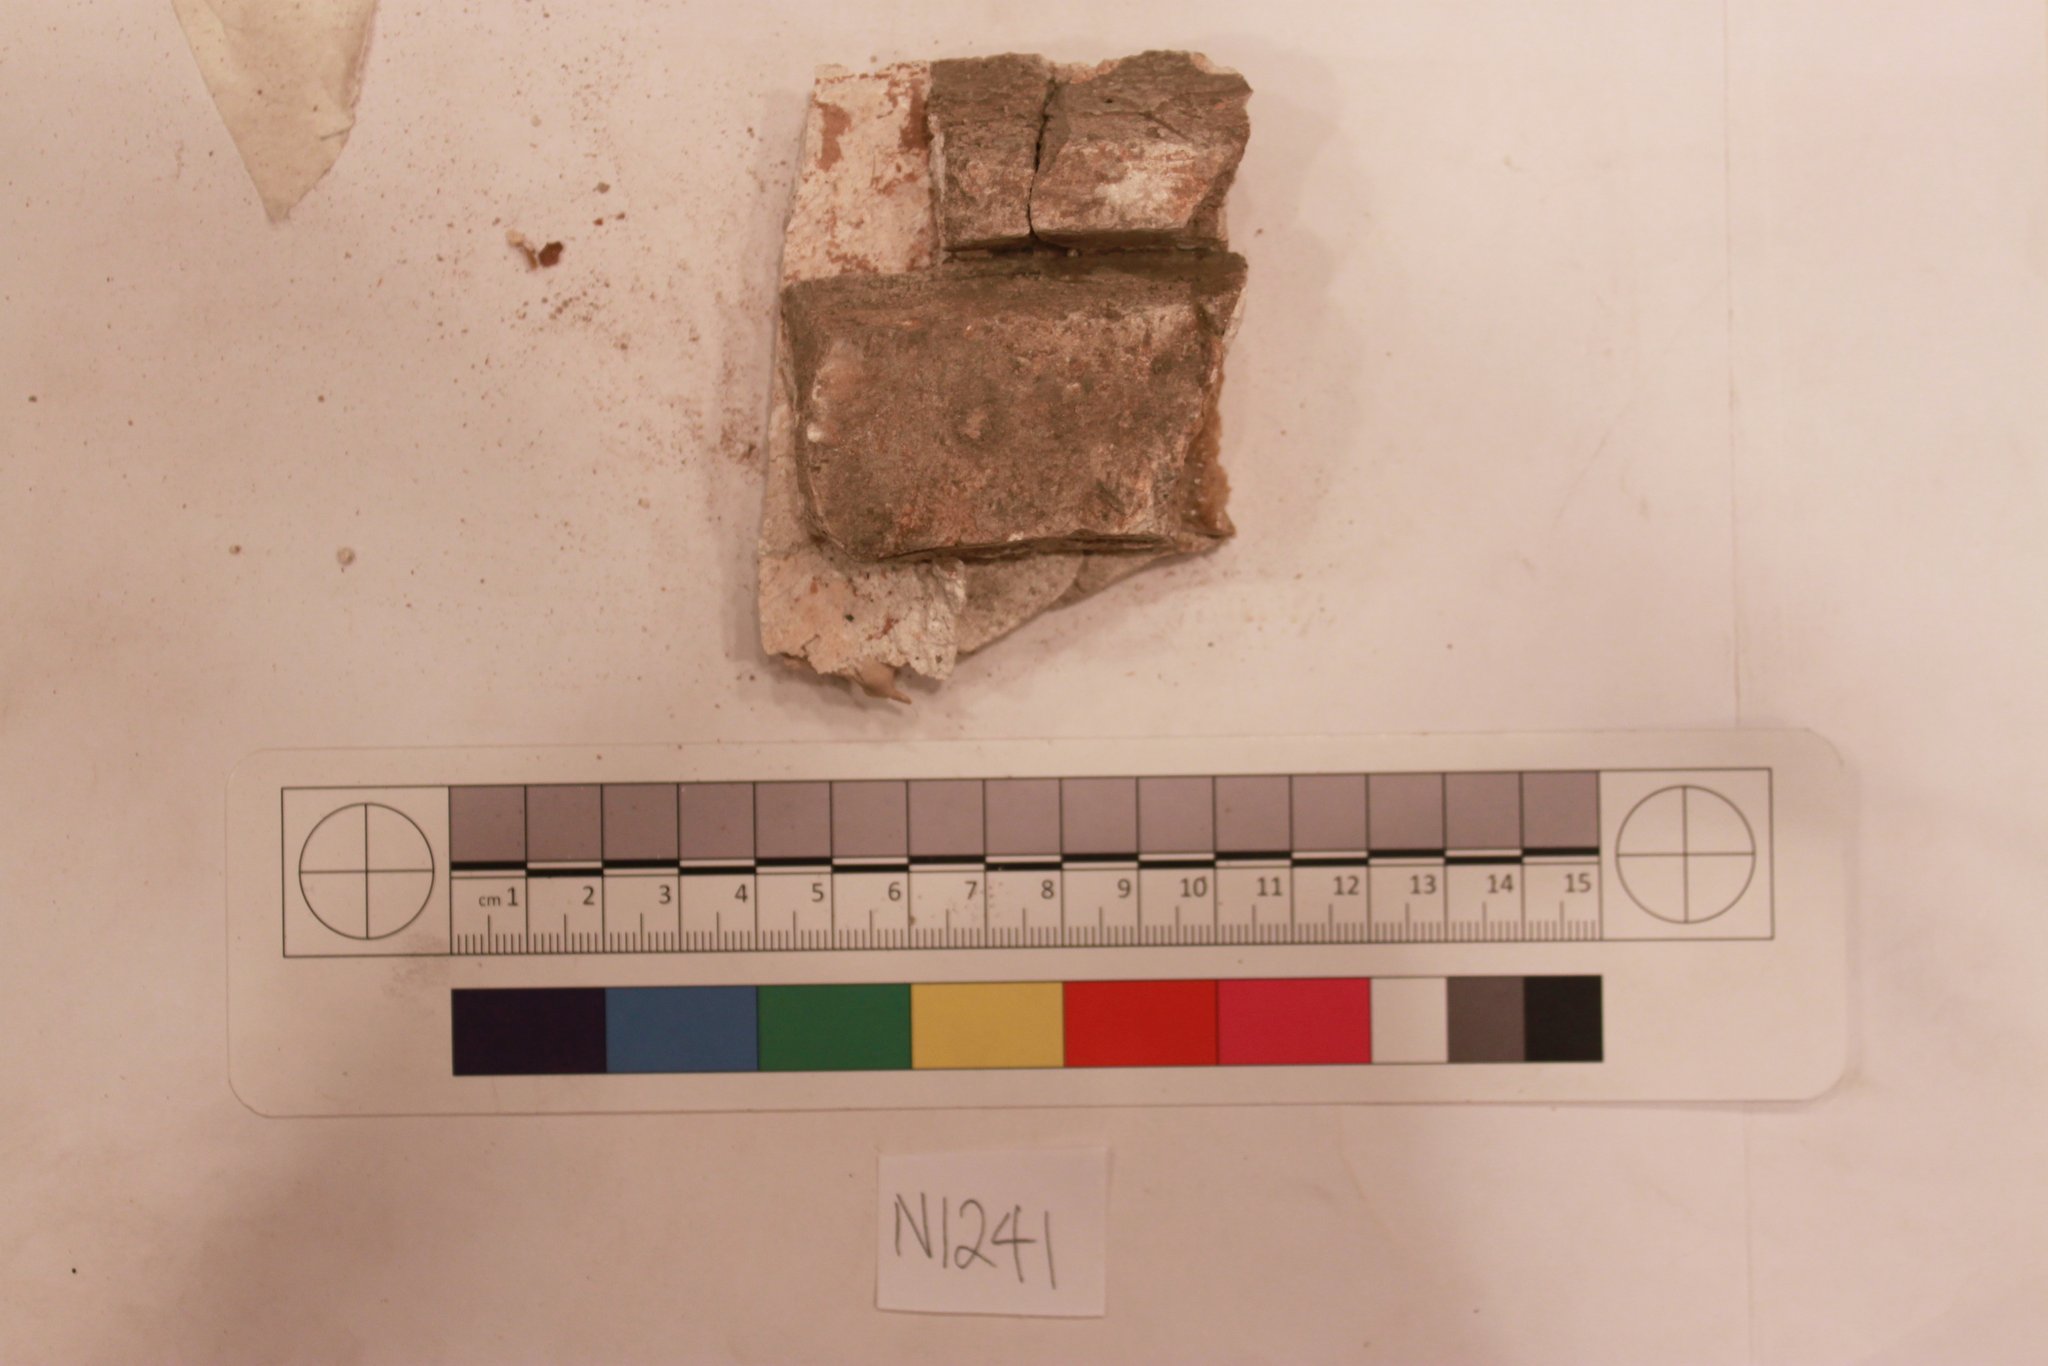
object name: fragment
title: Stucco Fragment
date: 701-1200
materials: plaster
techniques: carving, painting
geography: iran